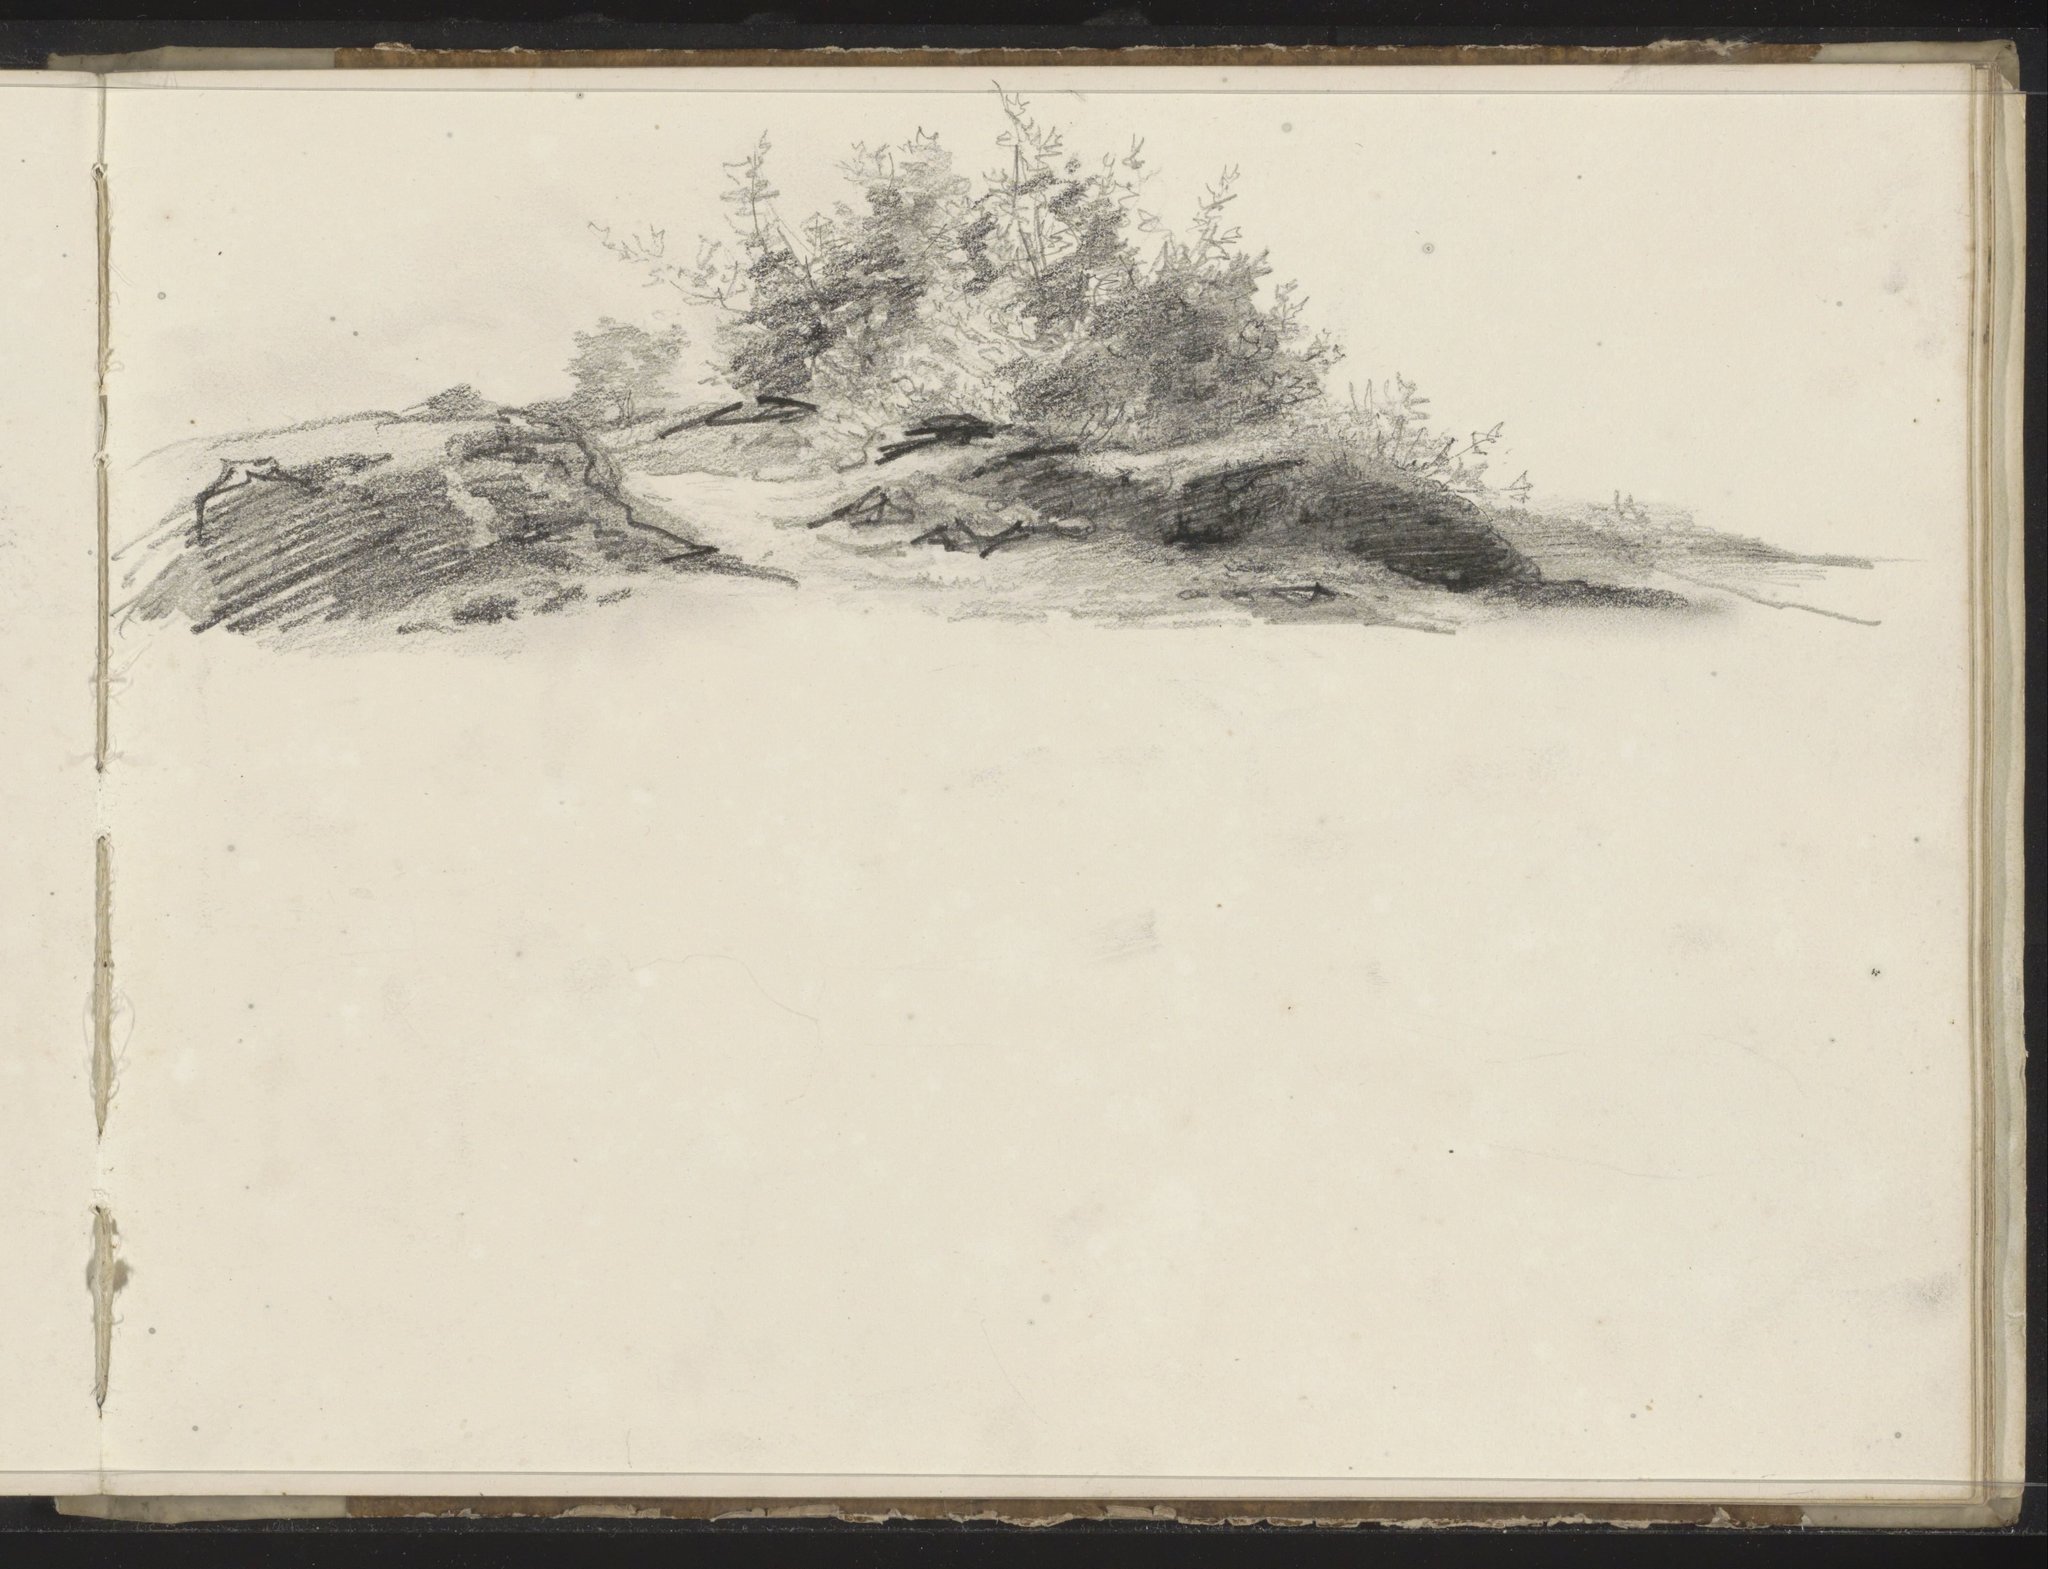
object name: sketchbook leaf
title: Landschap met struiken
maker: maria vos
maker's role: draughtsman, painter, print maker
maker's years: 1824-1906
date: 1834-1906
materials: paper, pencil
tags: landscapes, shrubs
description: Blad 25 recto uit een schetsboek met 39 bladen.